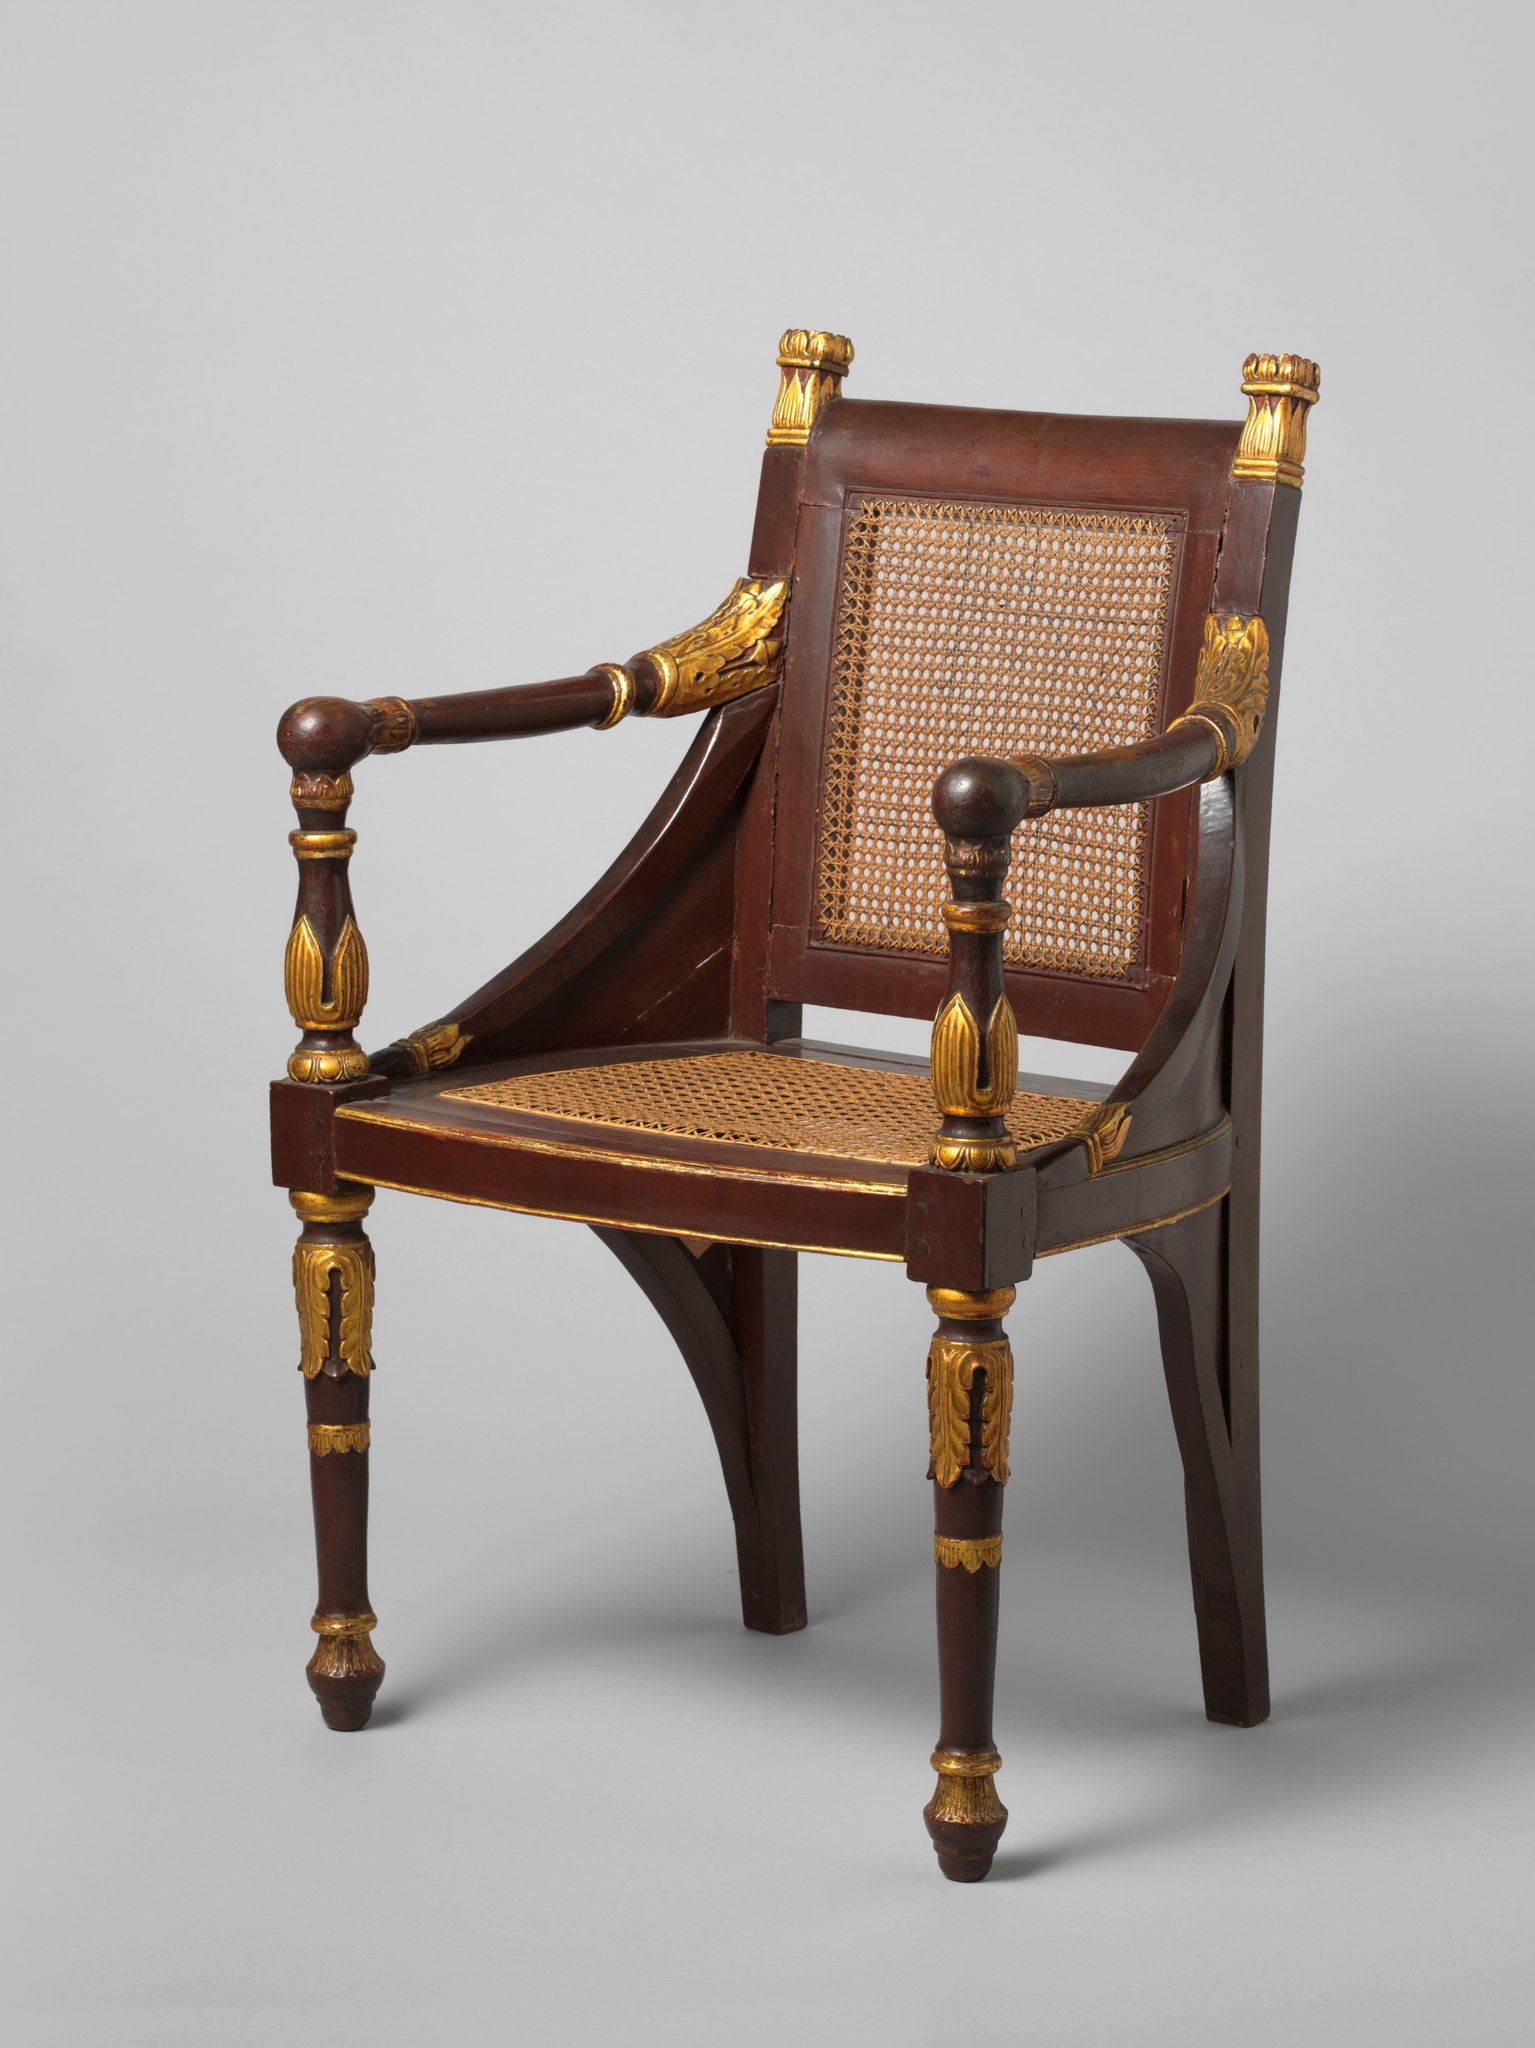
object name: seating furniture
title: Armstoel, Empire model, met rug en zitting van riet, rood geschilderd en met goud verguld en gehoogd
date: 1800-1825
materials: wood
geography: indonesia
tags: batavia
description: Twee armstoelen (A en B) van een tropische houtsoort (djati?), rood geschilderd, onderdelen verguld en met goud gehoogd, de rug en het losse zitraam met riet bespannen. Empire-model met rechte, iets naar achteren gewelfde rug, zich verbredende zitting met gebogen zijden, balustervormige voorpoten en armstutten, gebogen, in bollen eindigende armen en dichte wangen met verdiepte velden, die onder de zitregel in spiegelbeeld en in kleiner formaat herhaald worden. Gebeeldhouwd met acanthus- en palmetmotieven die verguld zijn. Onderlinge verschillen in proporties en detaillering. Op beide etiket: 'Deze stoel heeft eens gestaan in het Kasteel Batavia. Later is hij in gebruik geweest bij het Hoogergerechtshof van Nederlandsch Indië Wagener'. Nederlands-Indië, eerste kwart 19de eeuw.